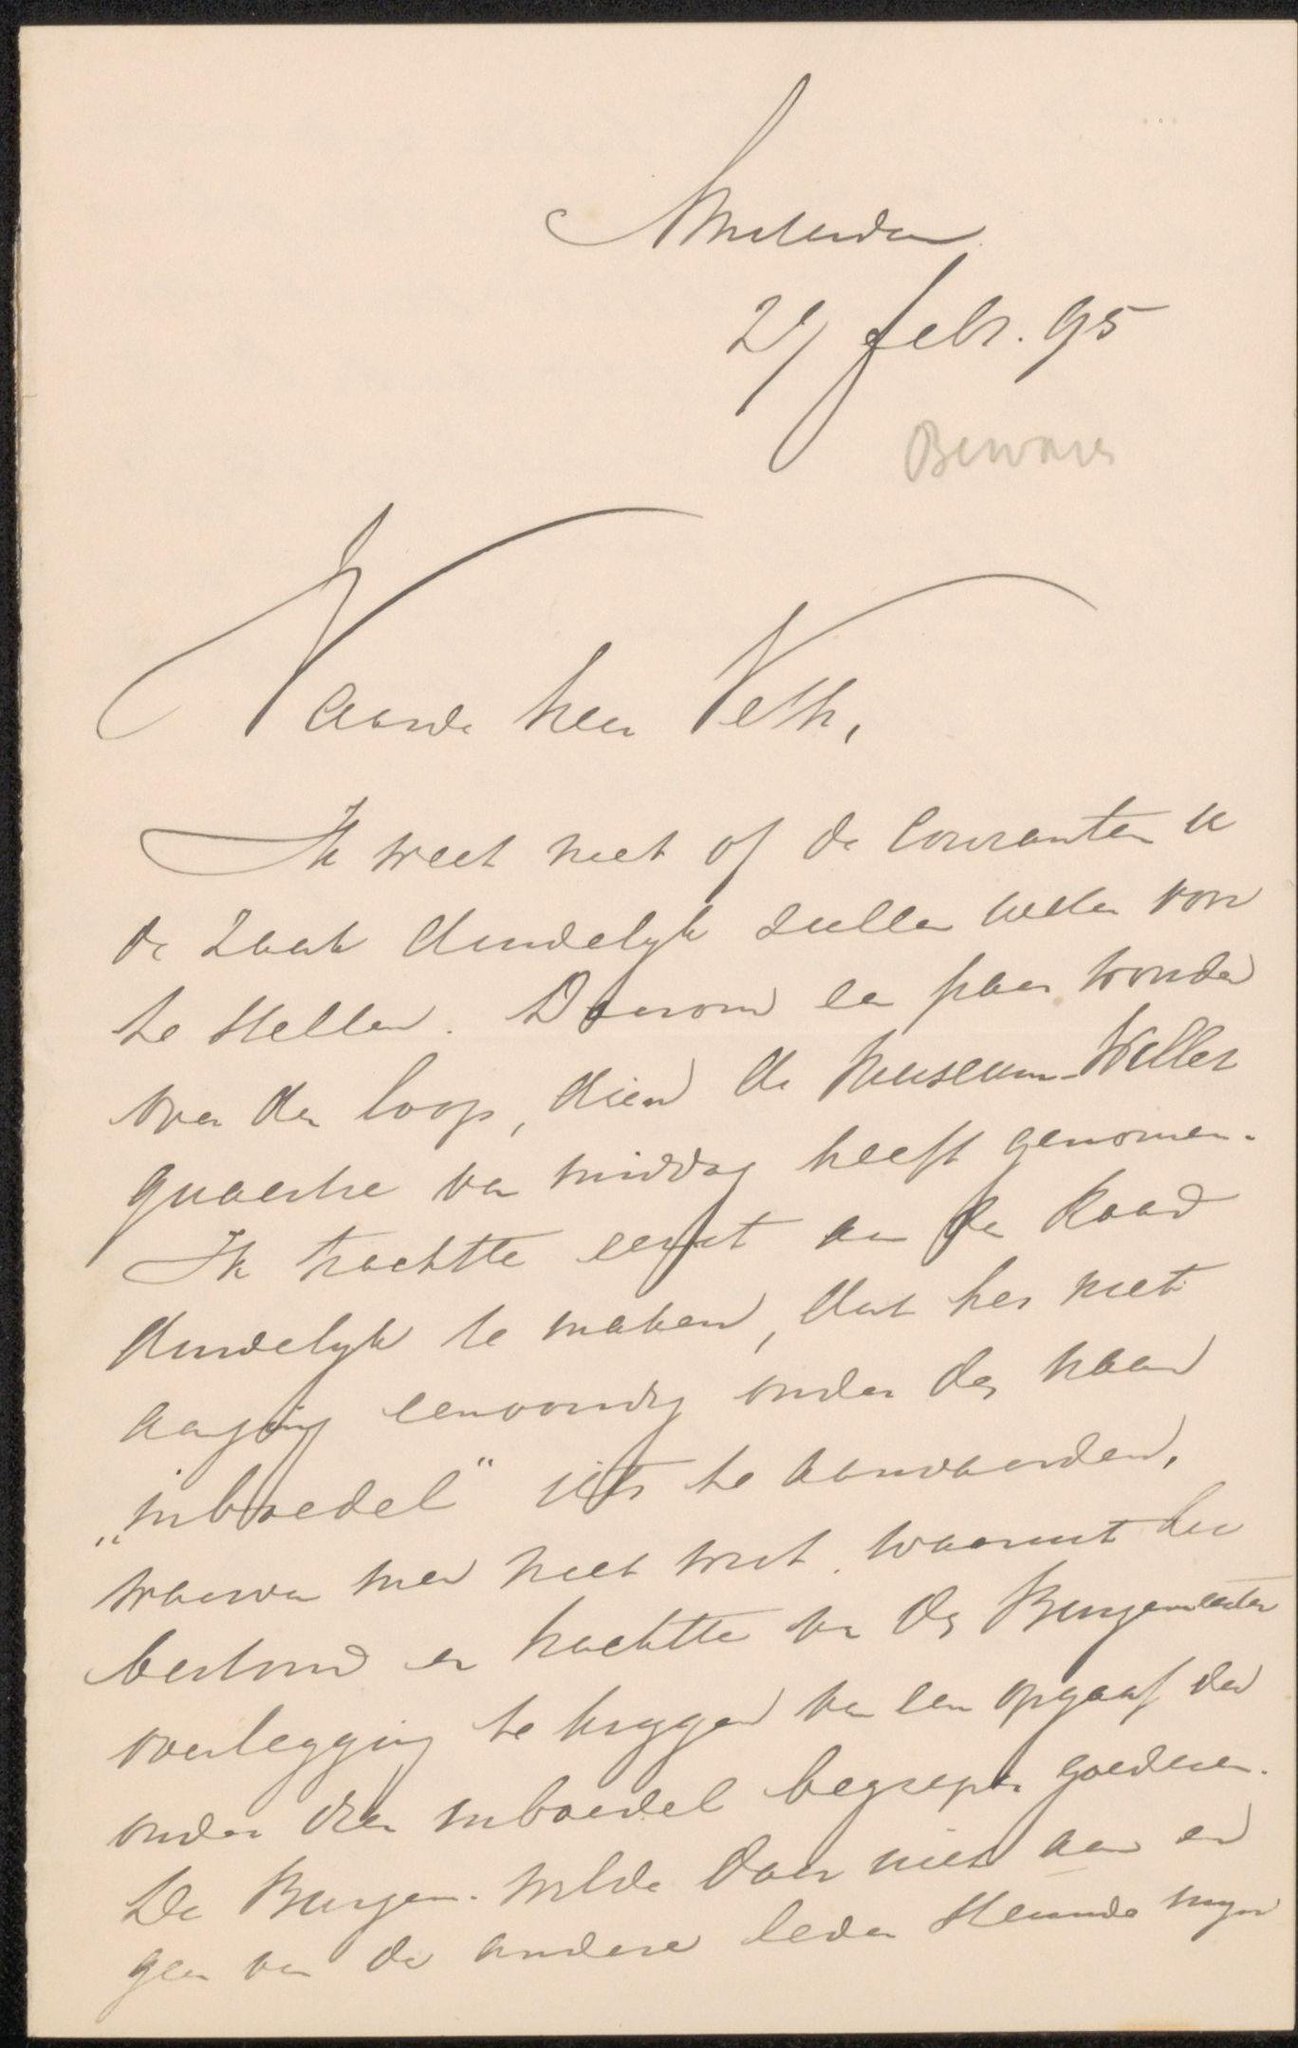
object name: letter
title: Brief aan Jan Veth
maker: jacob nicolaas van hall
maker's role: politician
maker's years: 1840-1918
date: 1895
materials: ink, paper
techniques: pen, writing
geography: amsterdam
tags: dordrecht, painter, print maker, draughtsman, designer, jan veth, printed matter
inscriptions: collector's mark: ‘RPK’, watermark